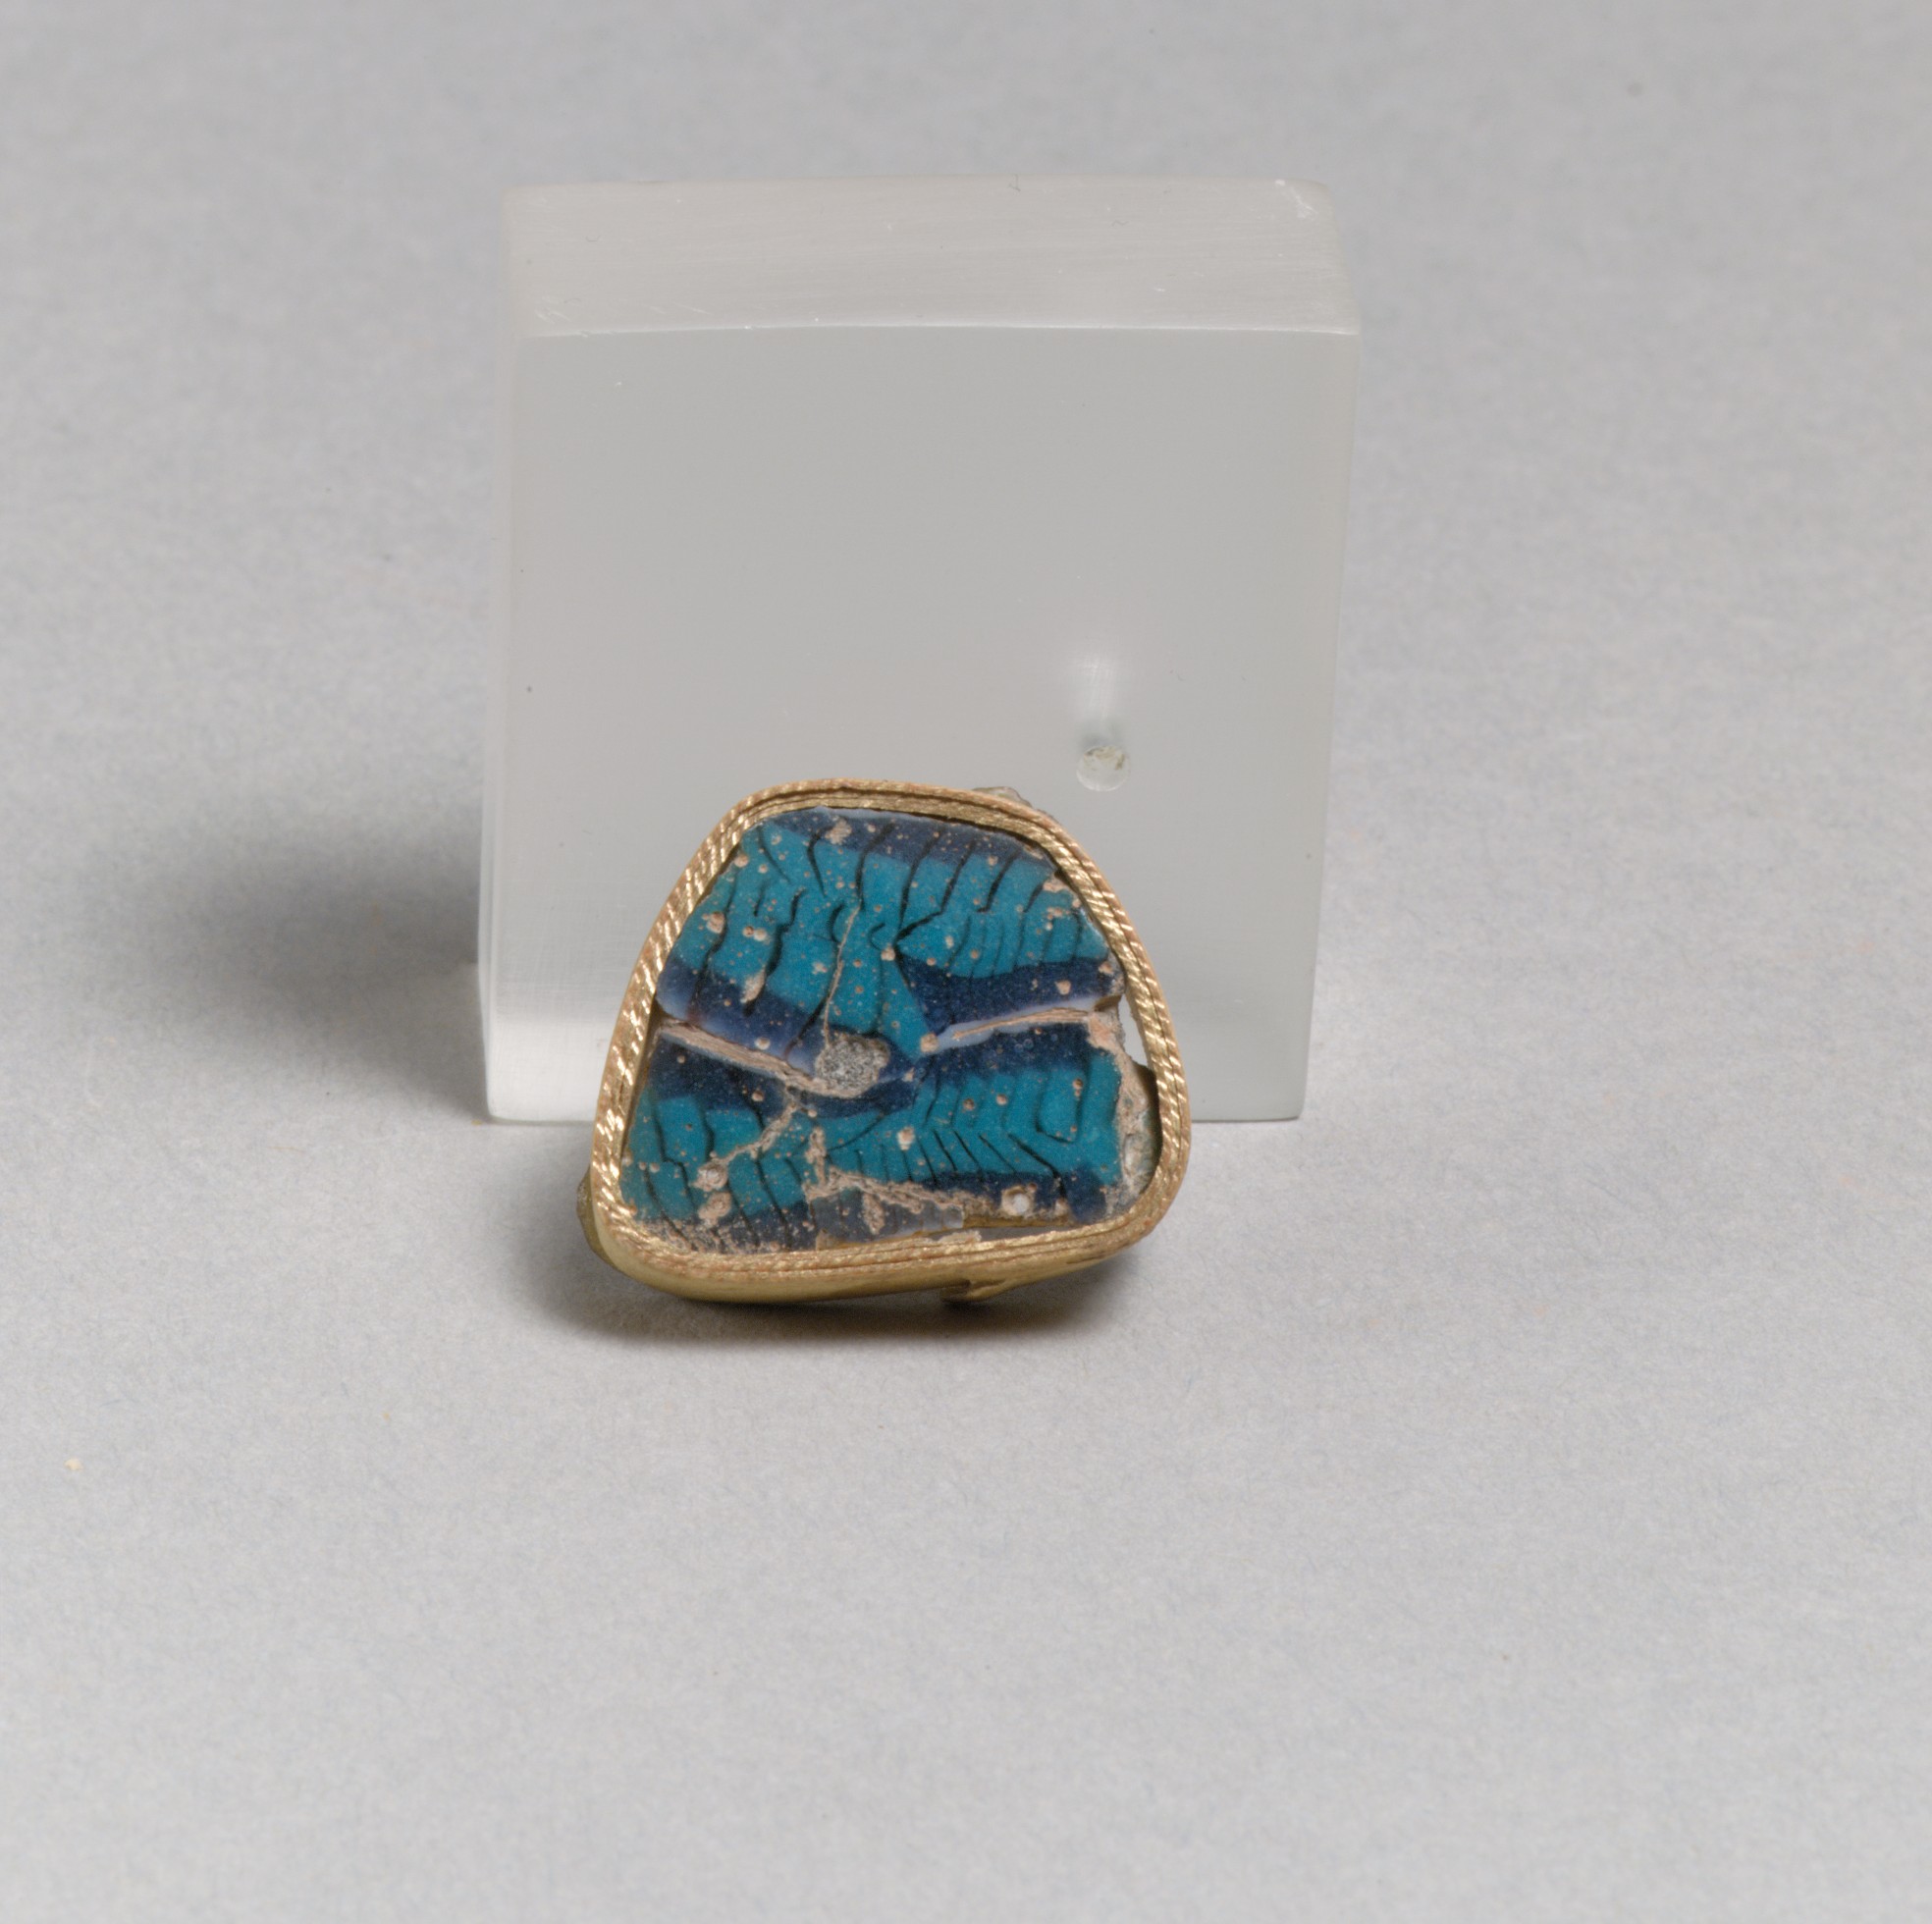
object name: fragment, mosaic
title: Glass mosaic inlay fragment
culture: roman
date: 34 BCE-33 CE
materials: glass